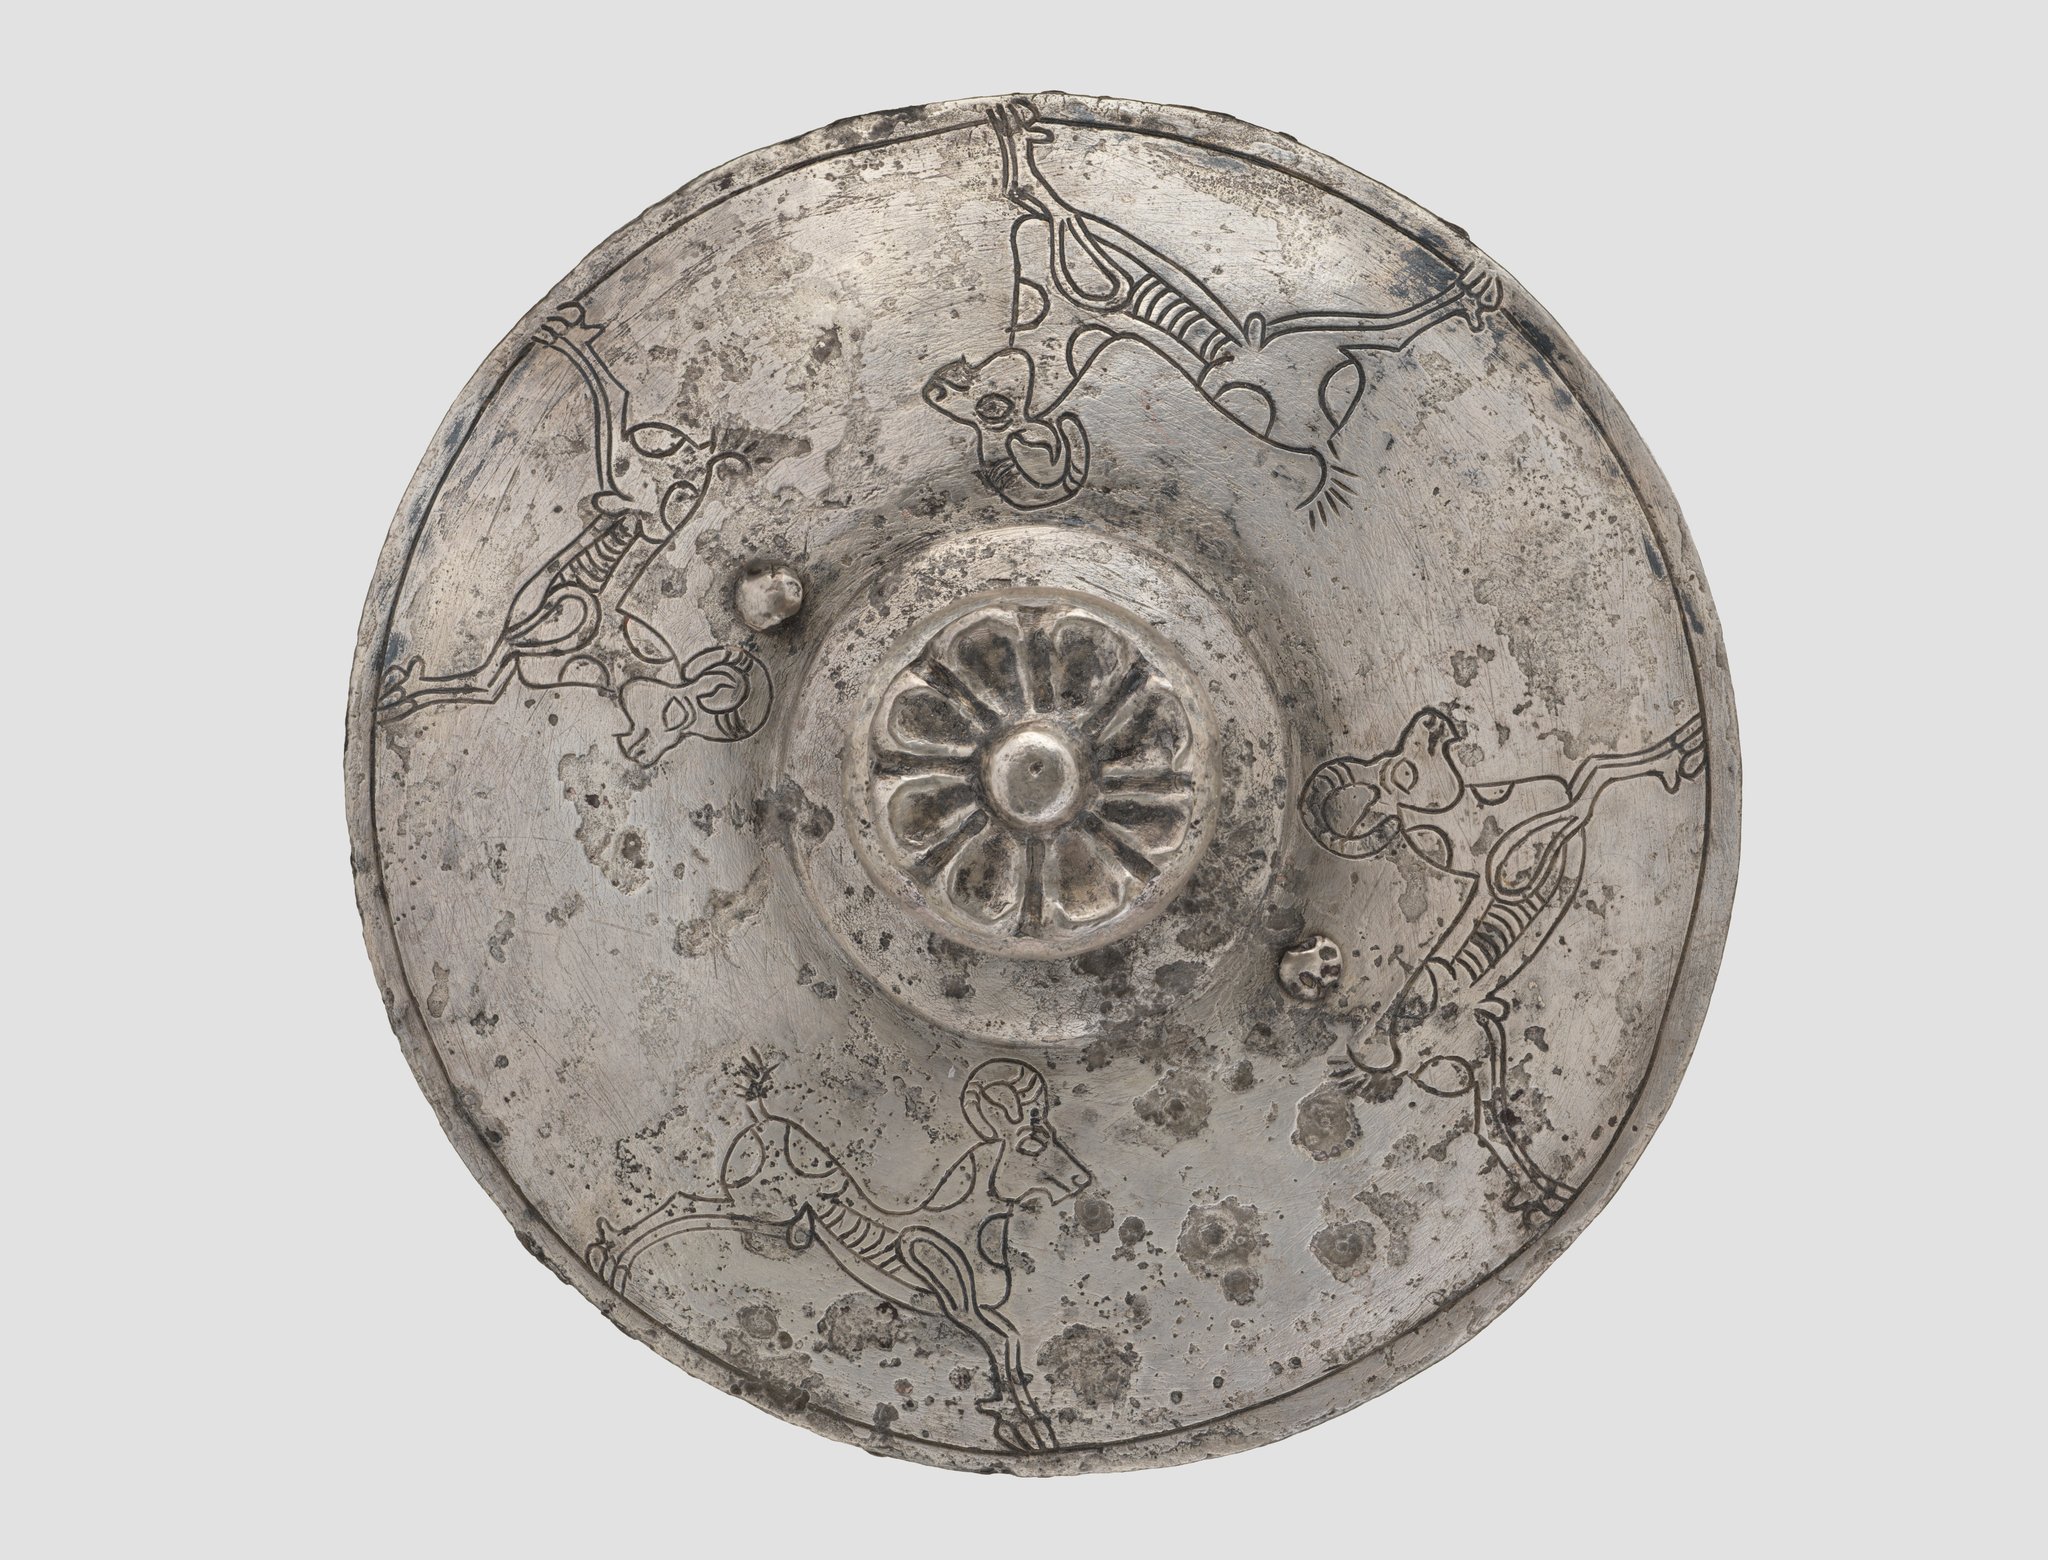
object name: bos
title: Decorated boss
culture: iranian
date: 800-601 BCE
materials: silver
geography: iran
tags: animals,ibex